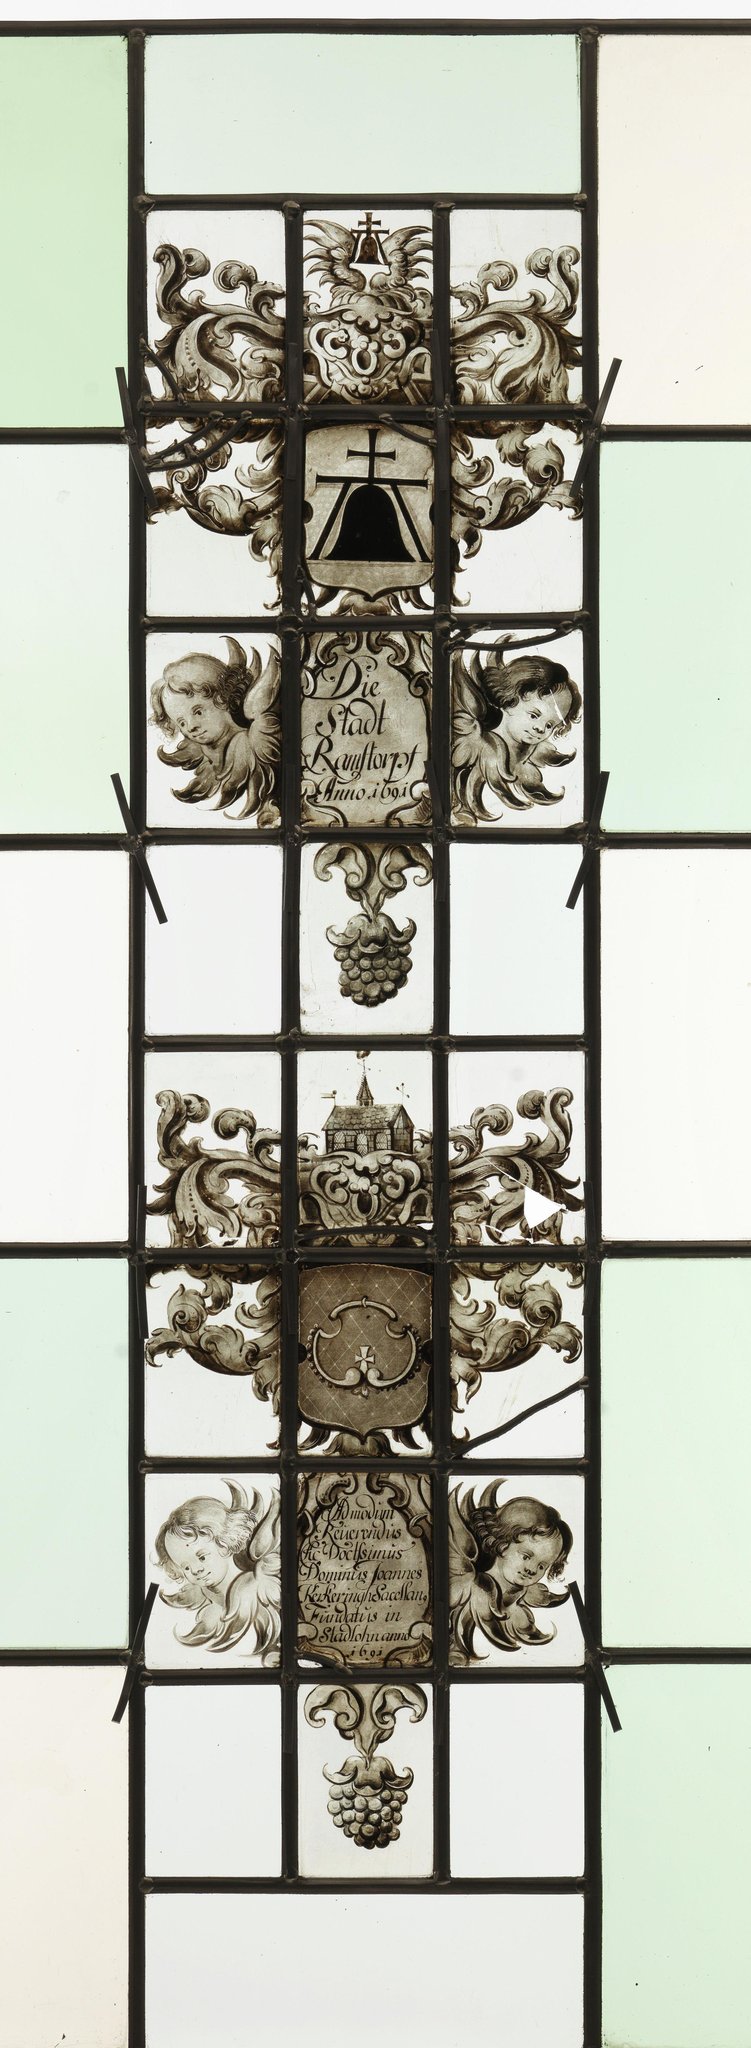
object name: light window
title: Ruit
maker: Anonymous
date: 1699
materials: glass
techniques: enamel painting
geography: westphalia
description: Ruit met gebrandschilderde voorstelling, vast aan BK-2000-10-C.